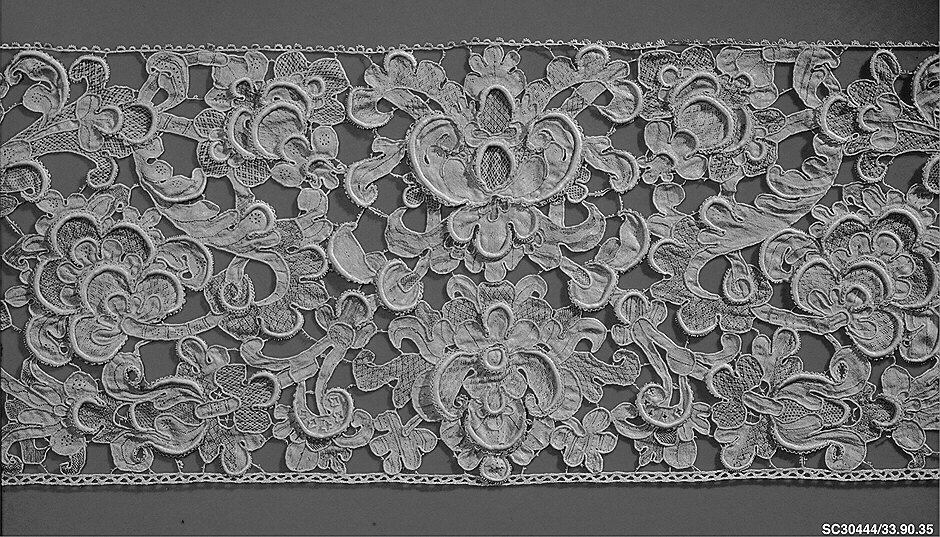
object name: border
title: Gros point needle lace border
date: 1651-1675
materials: lace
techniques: gros point, lace